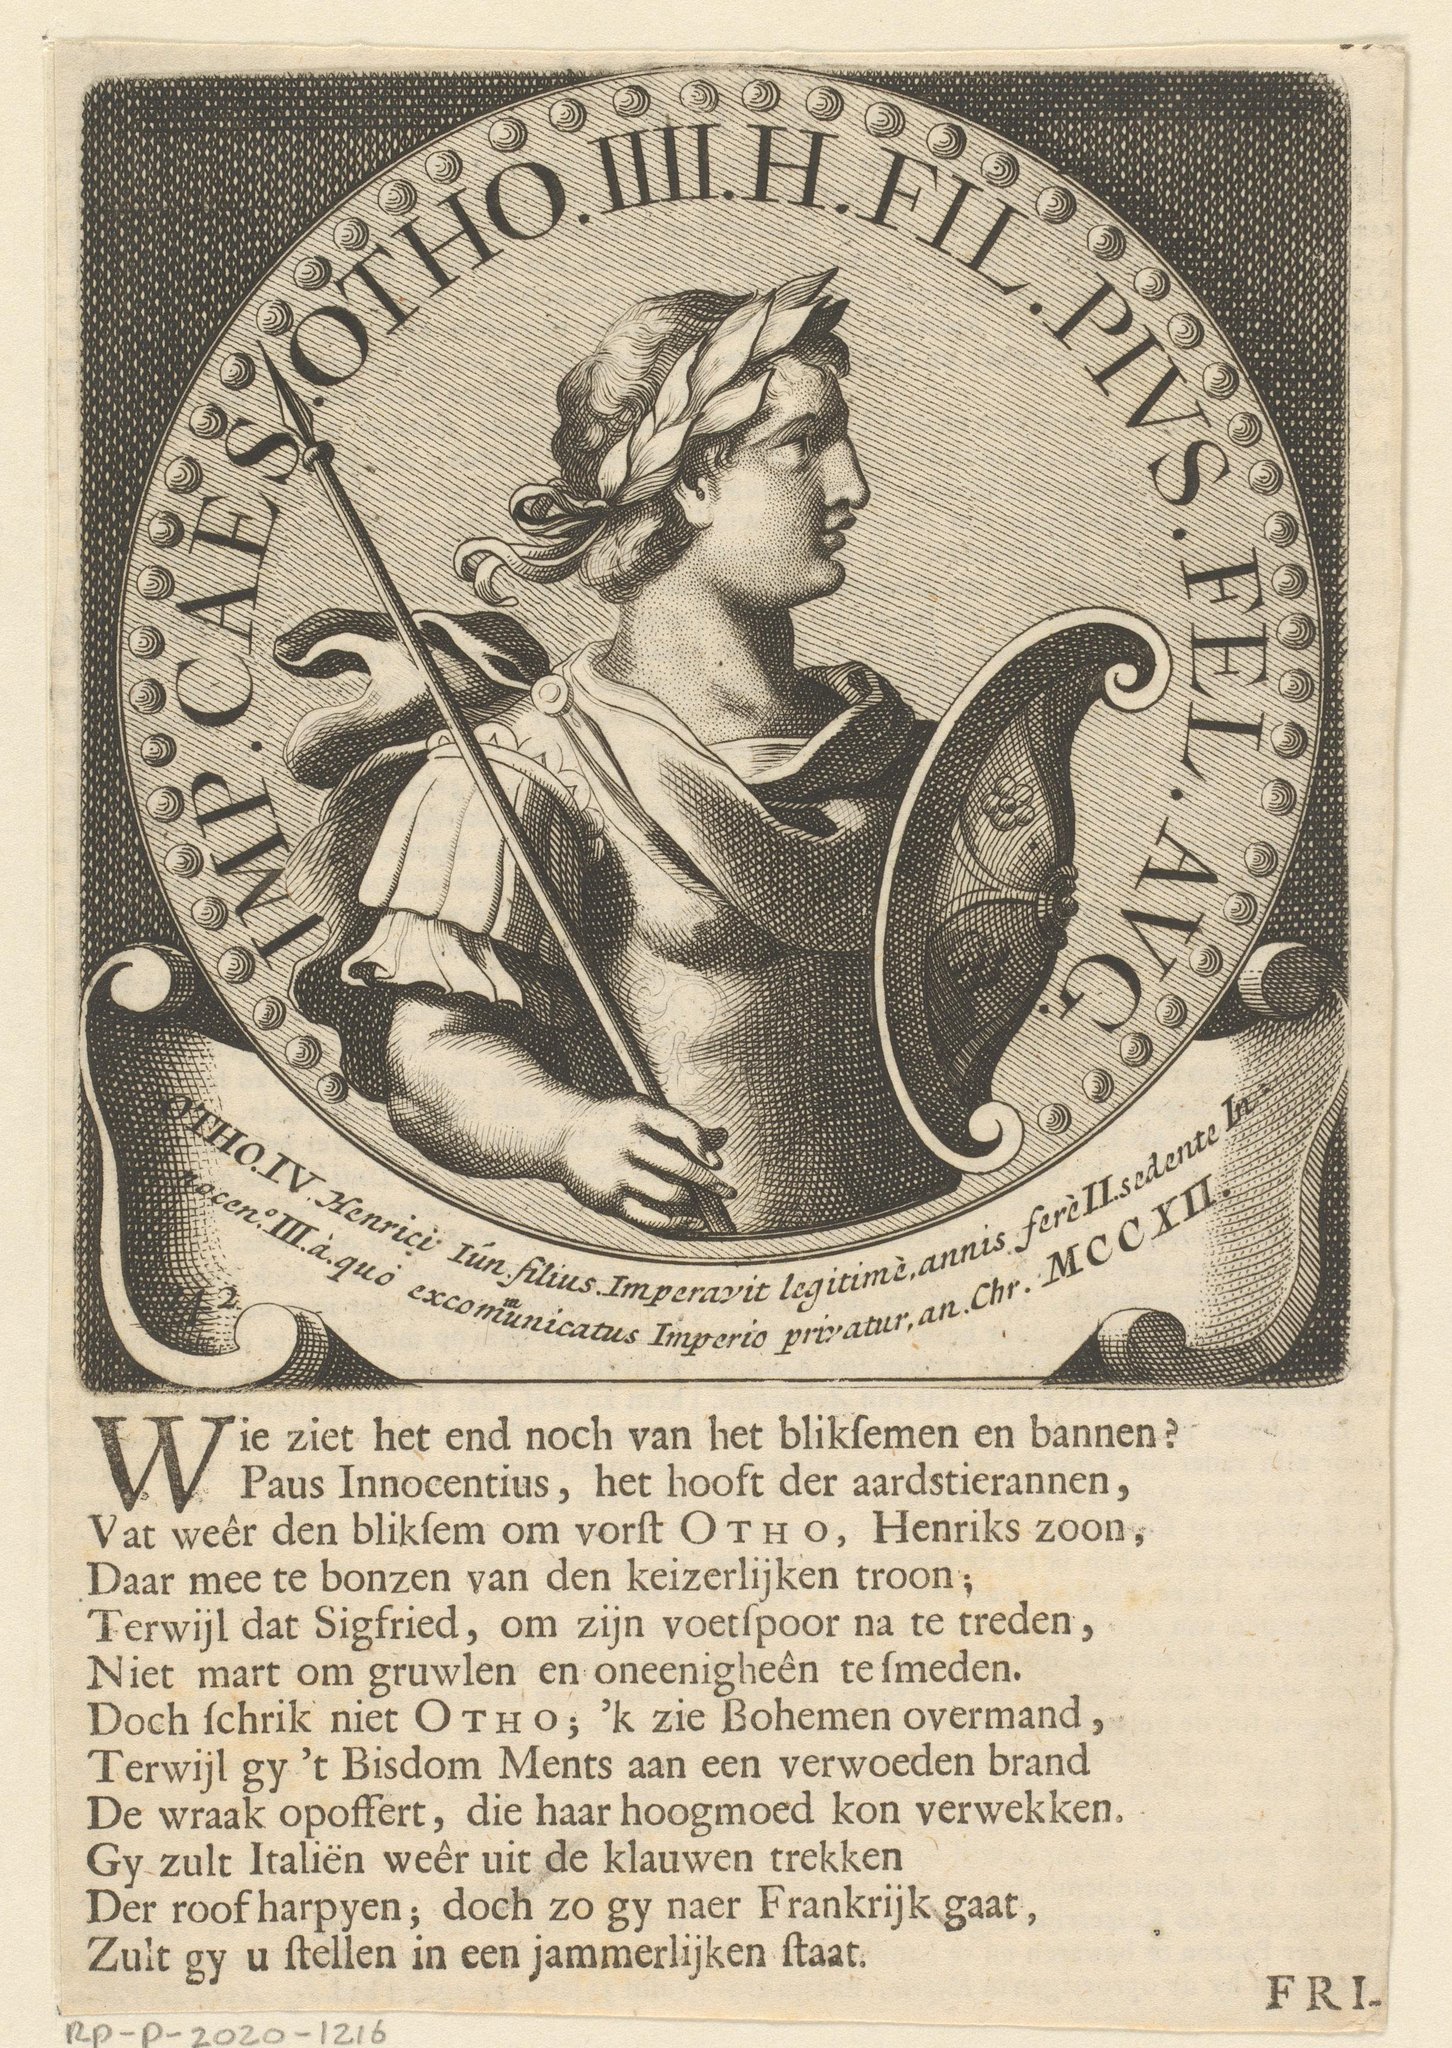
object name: print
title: Imp. caes. Otho. IIII. h. fil. pius. fel. Aug.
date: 1697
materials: paper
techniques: engraving, etching, letterpress printing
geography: utrecht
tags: protective weapons: shield, historical persons, casting weapons: spear, emperor, crowning with laurel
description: Prent uit: Bogaert, Abraham. De Roomsche monarchy, vertoont in de muntbeelden der westersche en oostersche keizeren (...). Utrecht: François Halma en Willem van de Water, 1697, p. 391. Eerste staat verschenen als grotere prent met 12 portretten, gedateerd 1695.